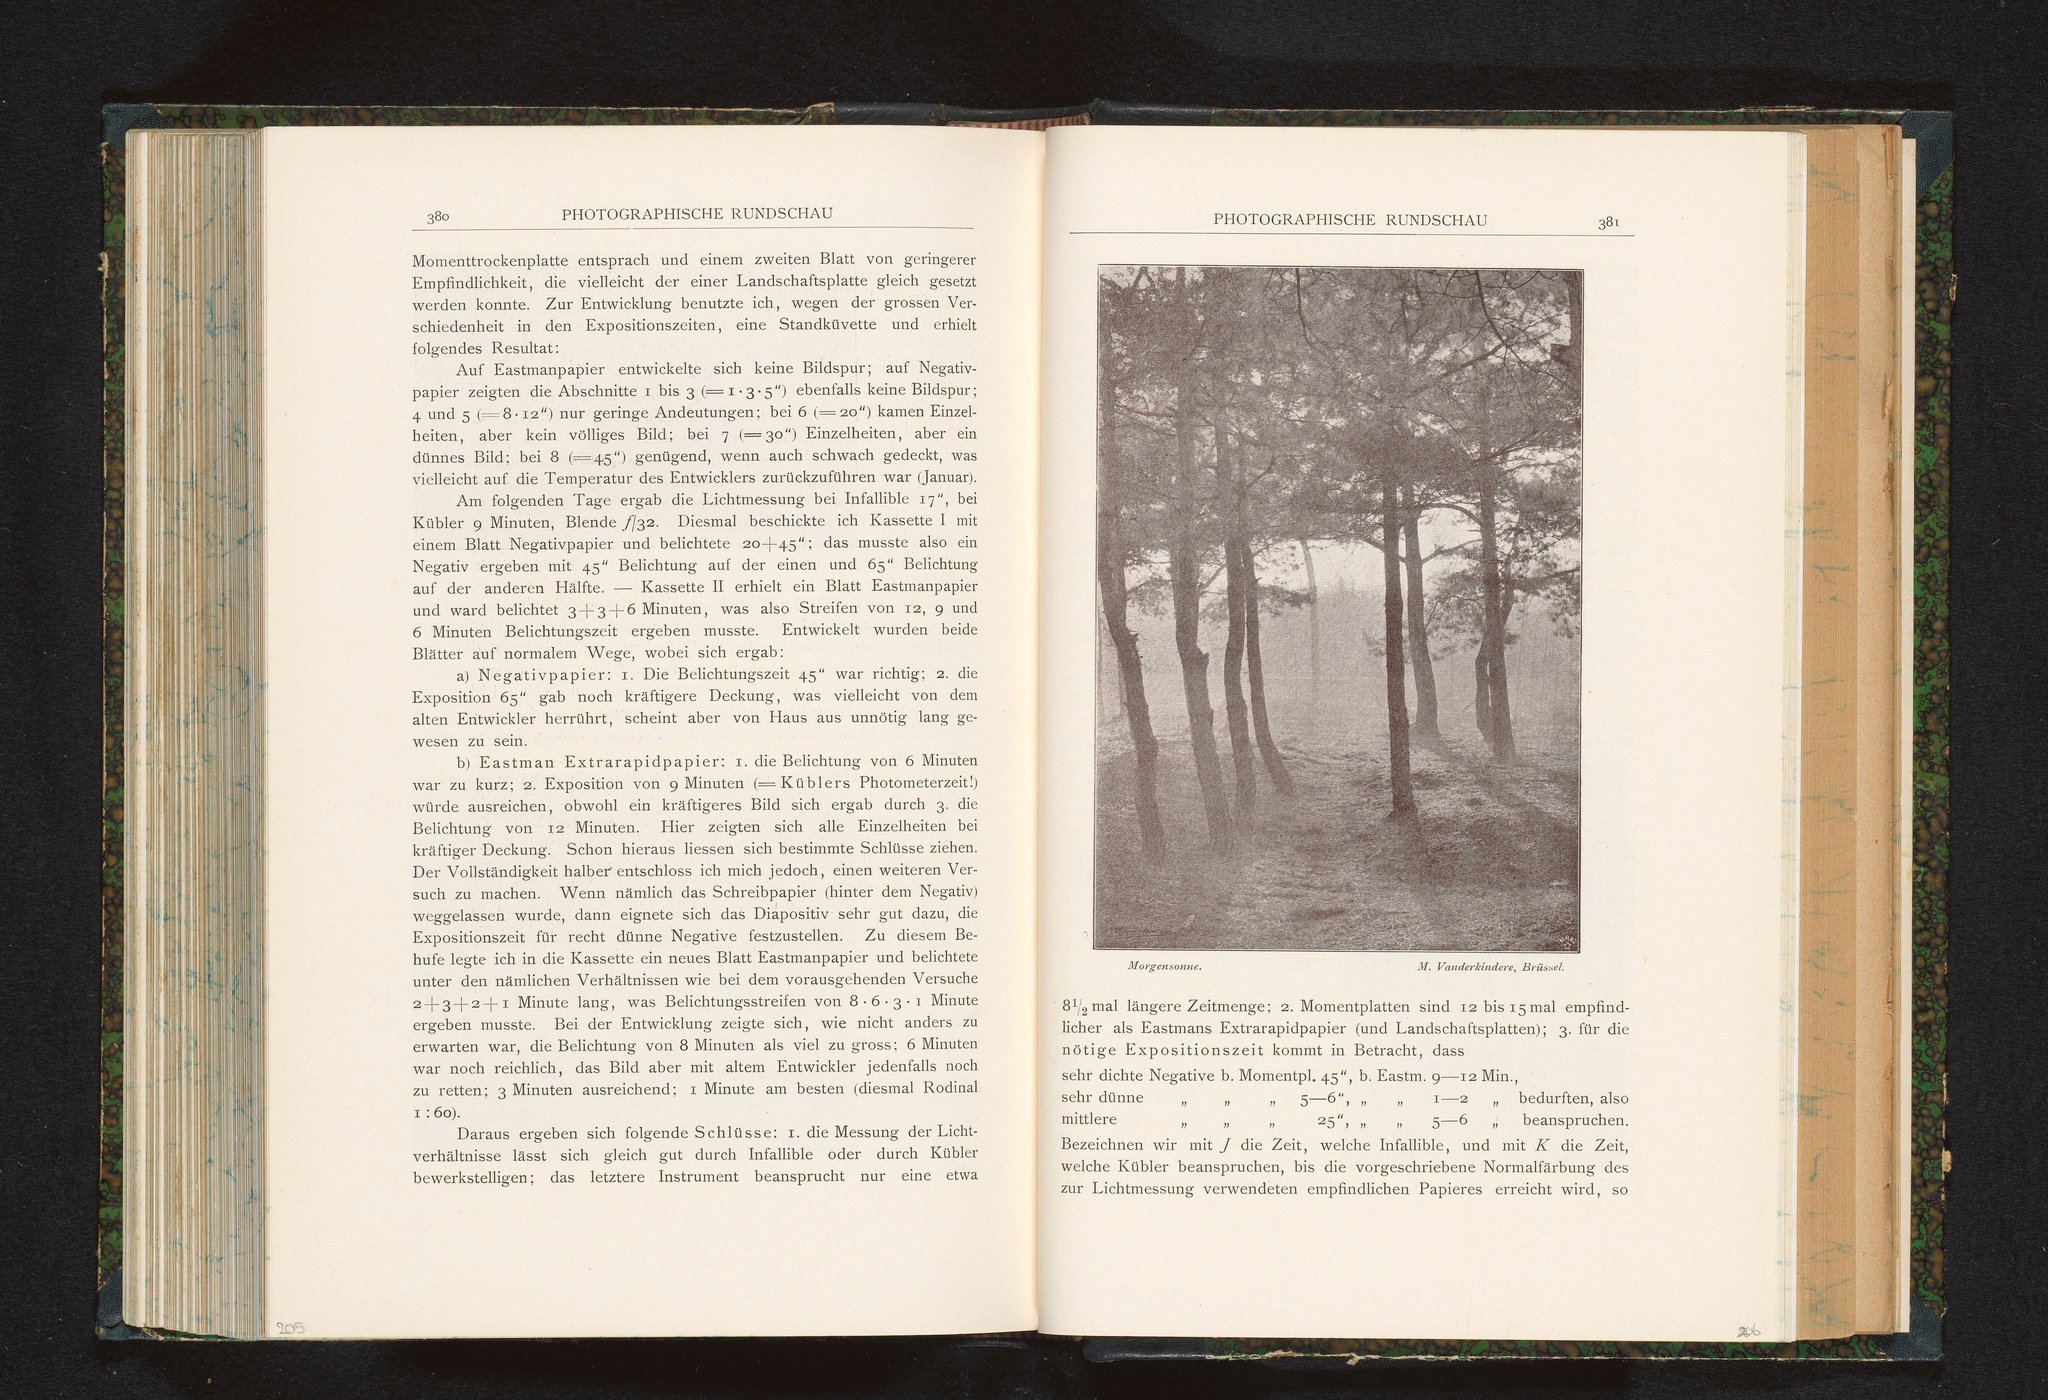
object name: photomechanical print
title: Bomen bij zonsopgang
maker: marcel vanderkindere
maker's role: fotograaf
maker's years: 1864-1941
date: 1894-1899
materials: paper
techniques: autotype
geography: berlin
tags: trees